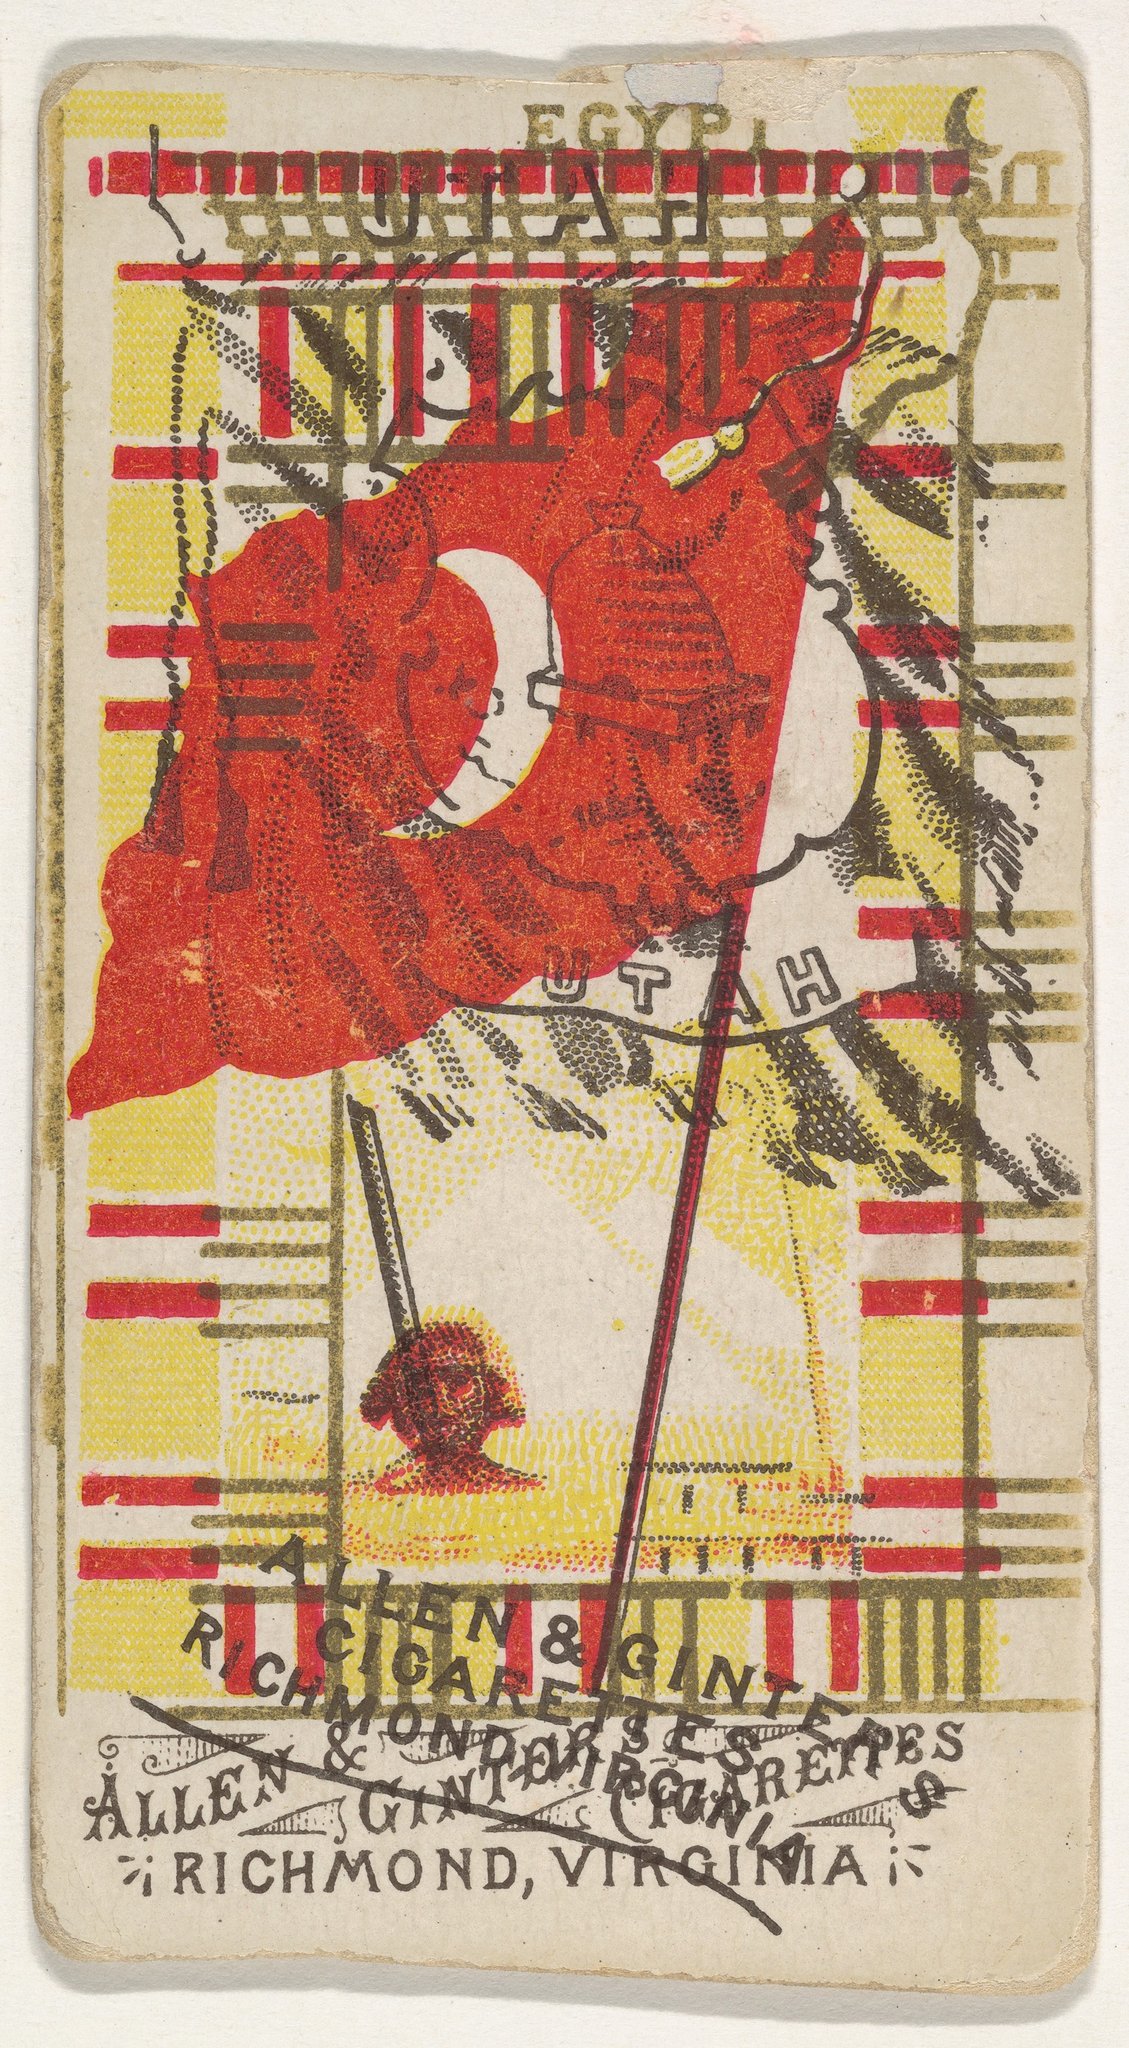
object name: print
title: Egypt and Utah (double-printed card), from Flags of All Nations, Series 1 (N9) for Allen & Ginter Cigarettes Brands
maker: allen & ginter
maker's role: publisher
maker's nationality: american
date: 1887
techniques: color lithograph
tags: flags